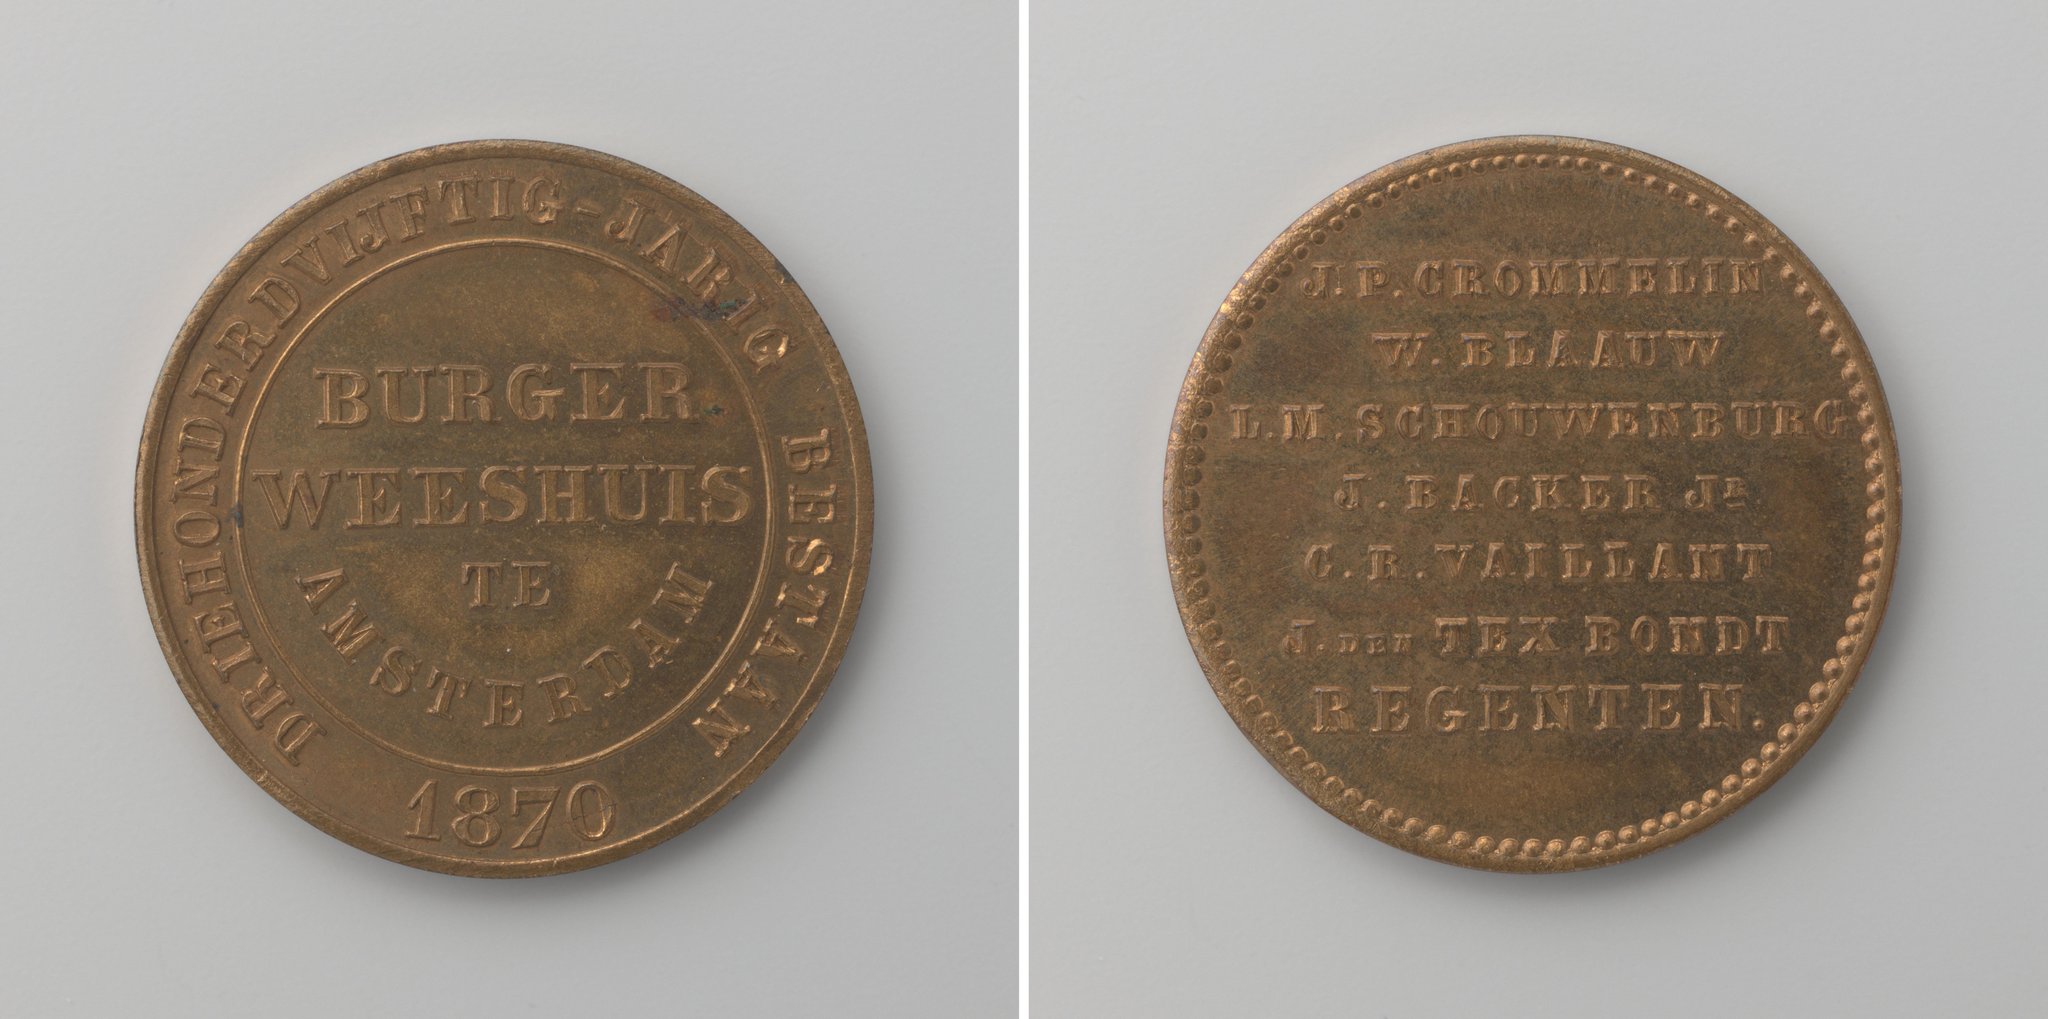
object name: history medal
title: Driehonderdvijftigjarig bestaan van het Burgerweeshuis te Amsterdam 1870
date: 1870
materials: brass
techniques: striking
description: Messing penning, op de voorzijde vier regels tekst met omschrift, op de keerzijde zeven regels tekst.